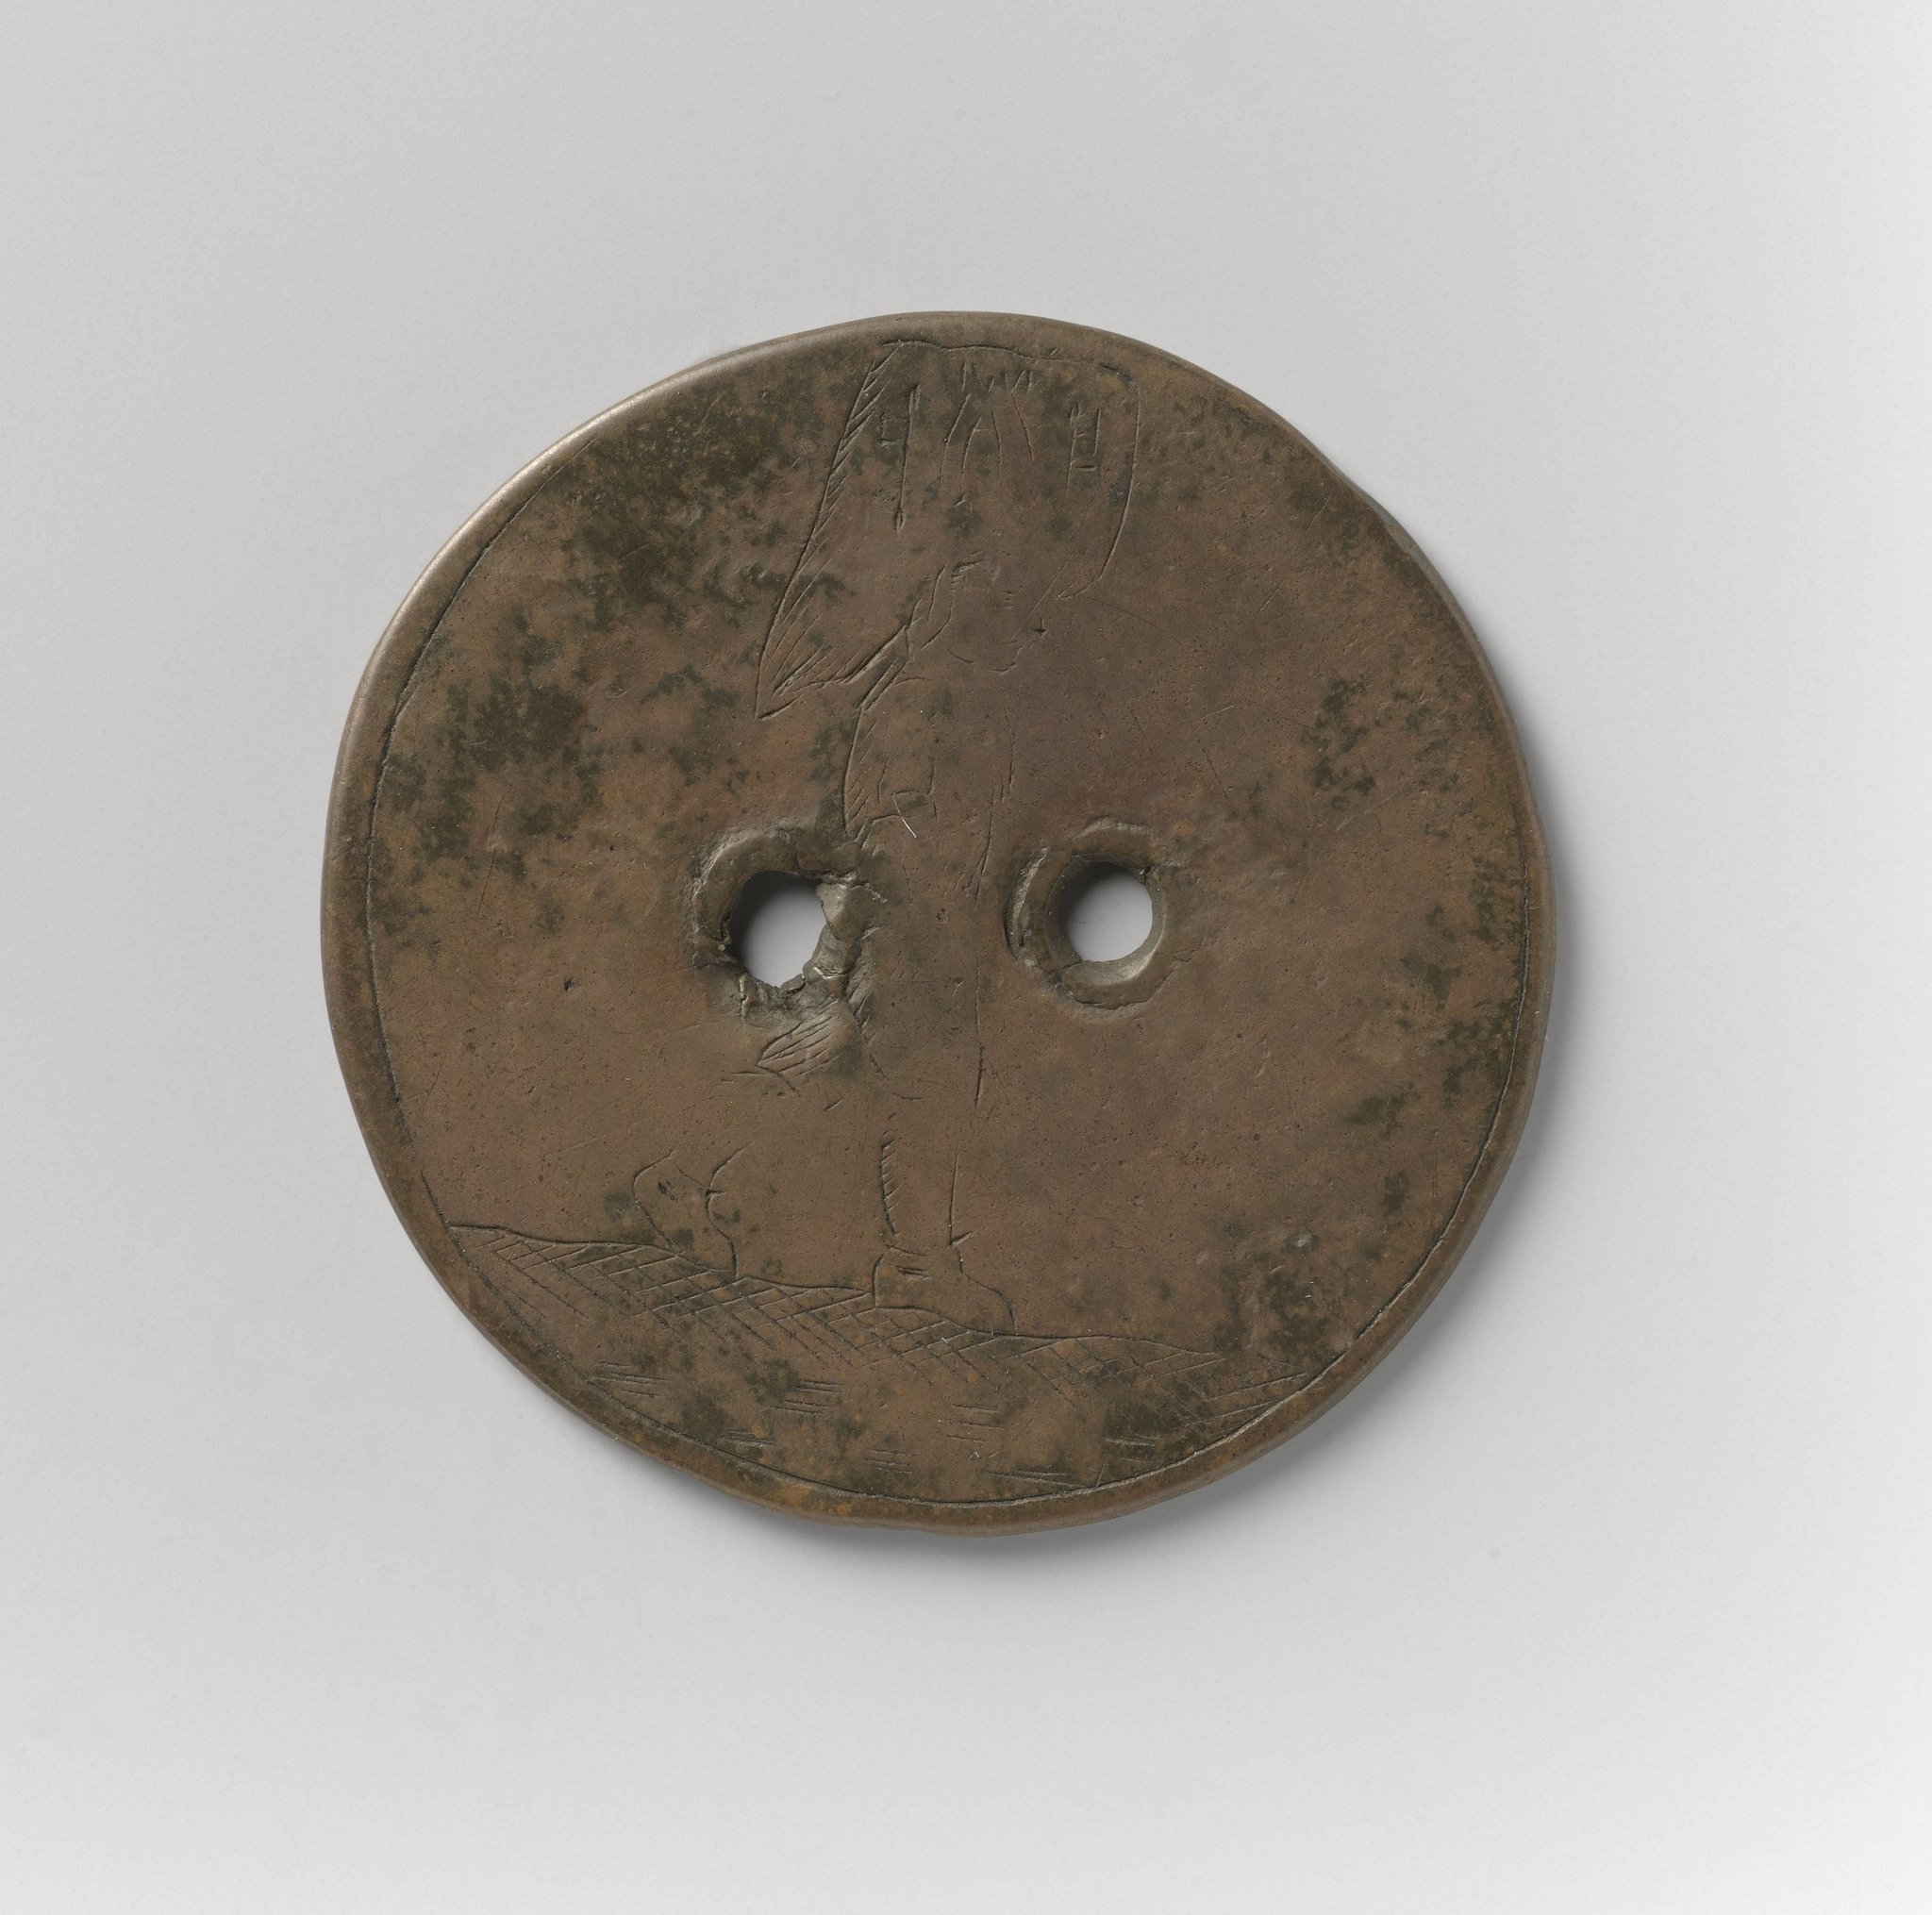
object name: medal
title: Korendragers- en -stortersgilde van Amsterdam, gildepenning van Adryaen Benne van hier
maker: Anonymous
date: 1700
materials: copper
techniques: engraving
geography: amsterdam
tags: amsterdam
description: Koperen penning met twee gaten erin; v.z:naar rechts gewende man met last op hoofd. Keerzijde: opschrift